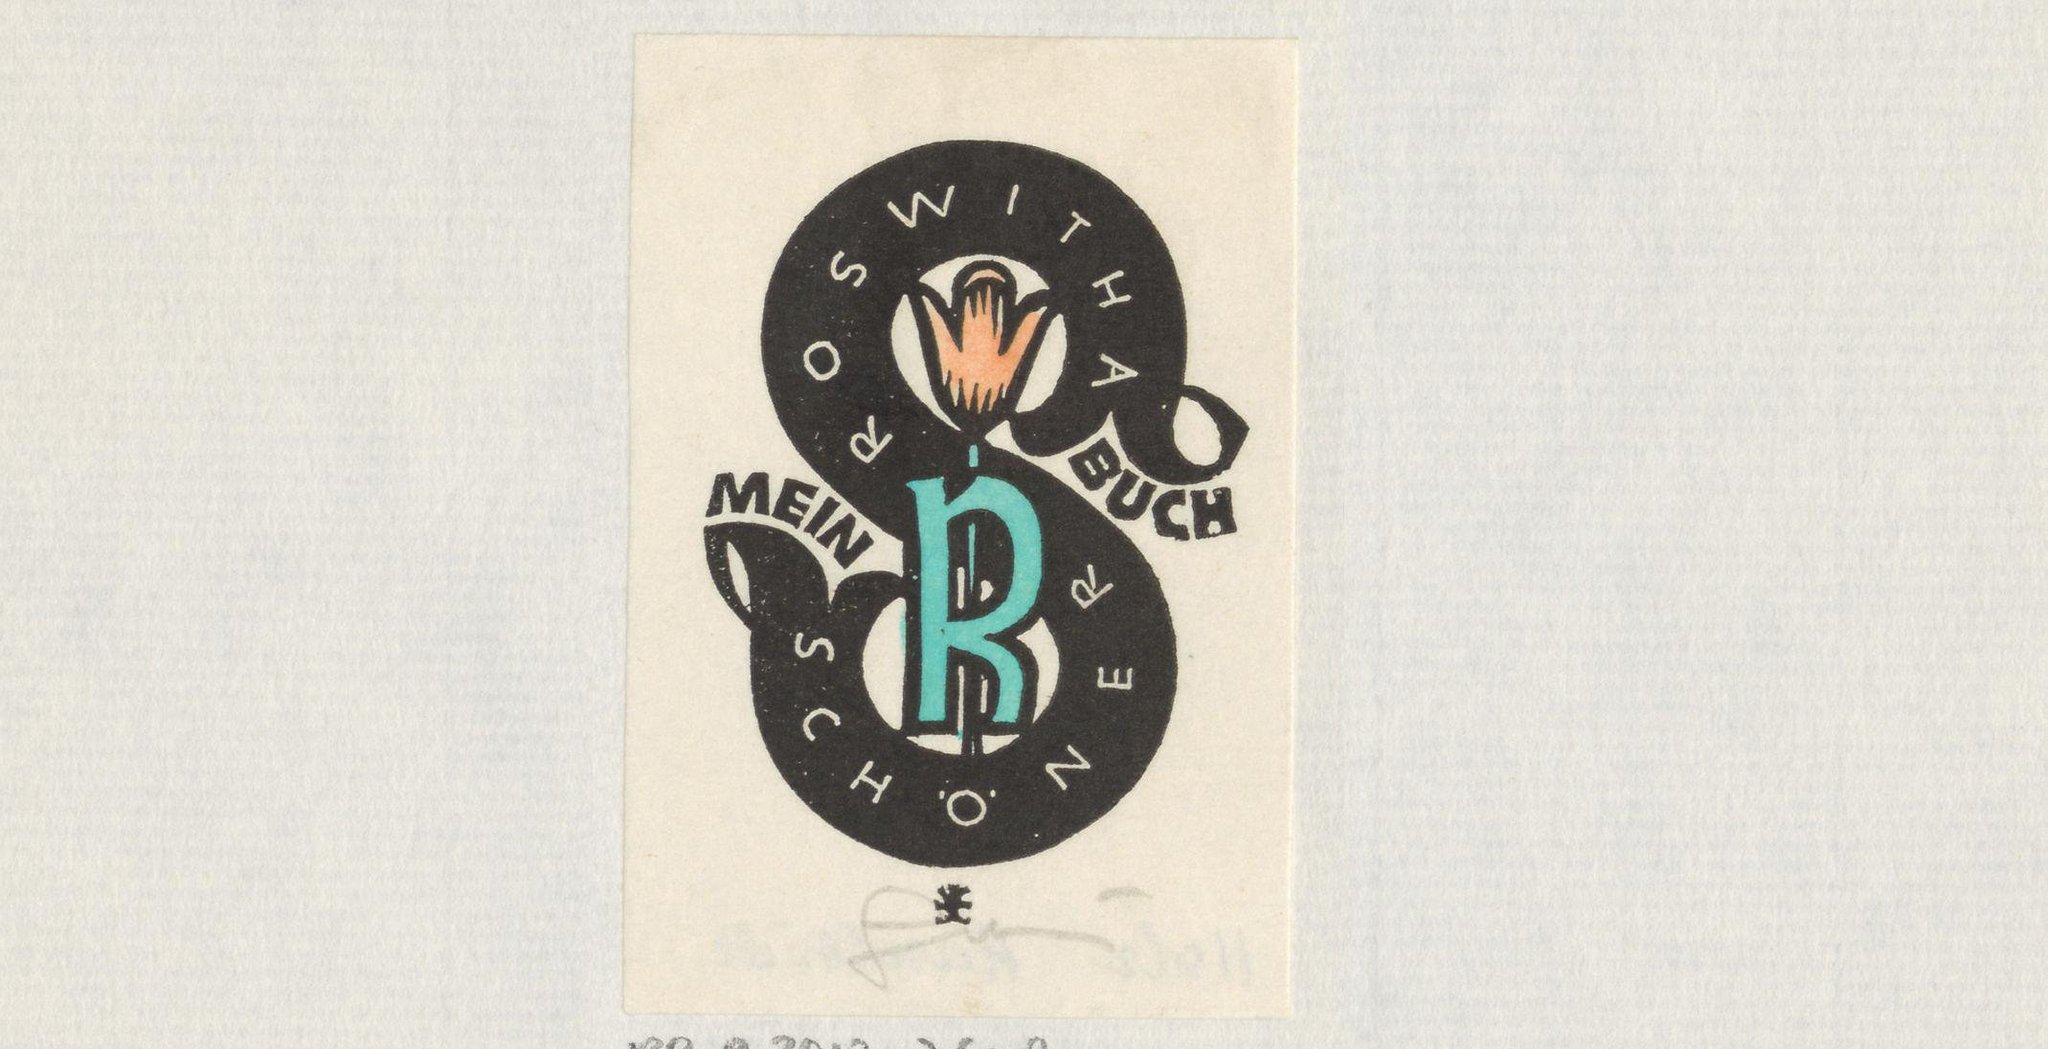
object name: bookplate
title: Mein/ Buch/ Roswitha/ Schöner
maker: karl haselböck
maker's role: print maker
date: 1954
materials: paper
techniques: hand coloring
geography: austria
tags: flowers: tulip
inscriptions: signature